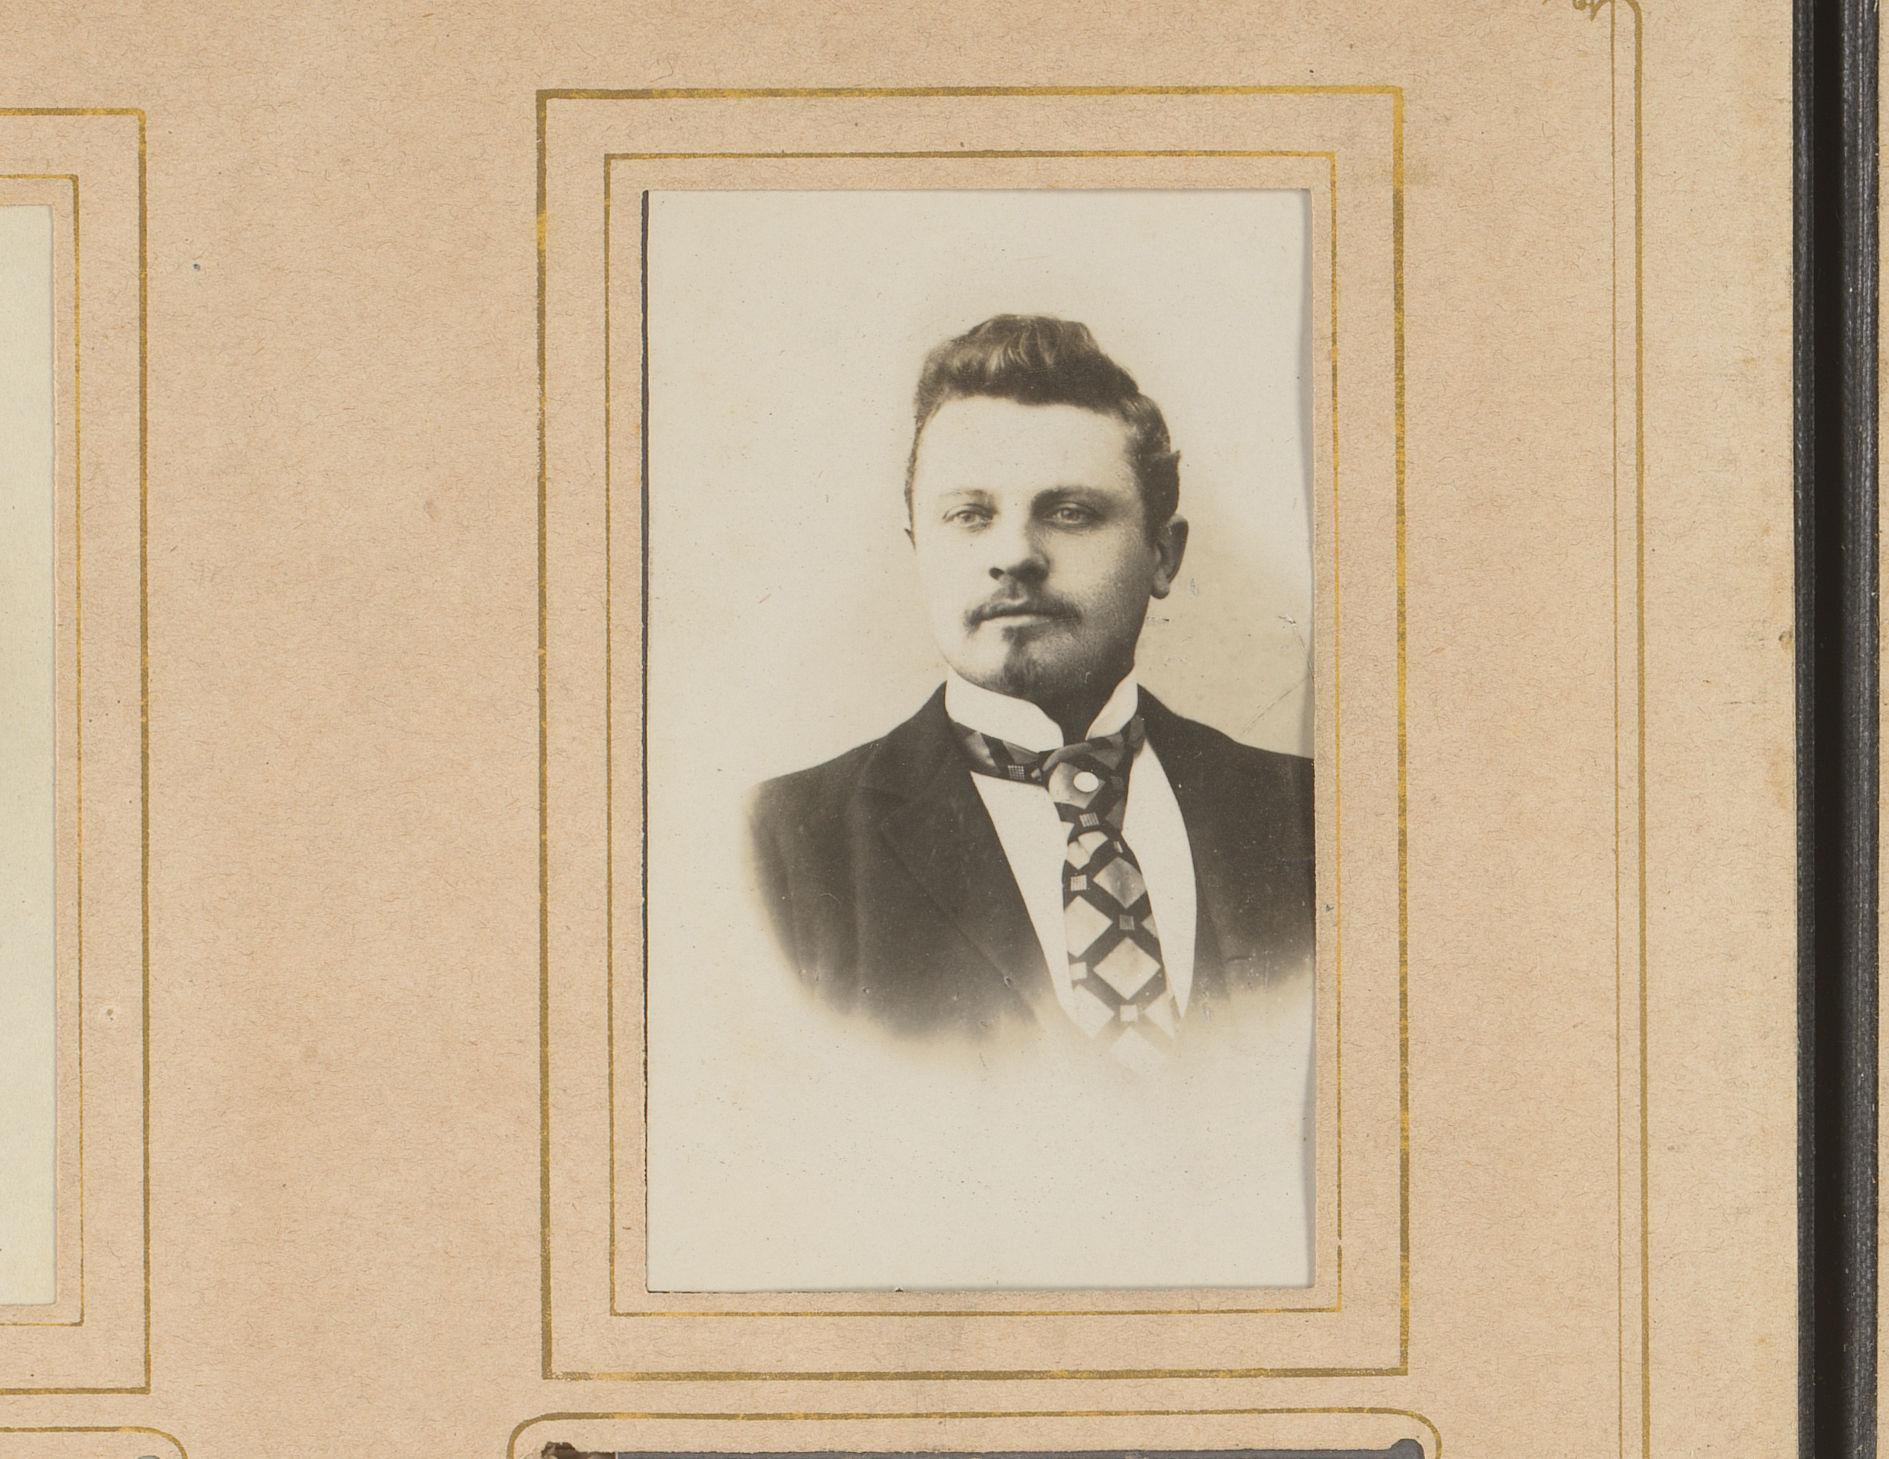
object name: album leaf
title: Portret van een man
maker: Anonymous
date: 1880-1915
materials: cardboard, photographic support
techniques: gelatin silver print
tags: adult man, historical persons